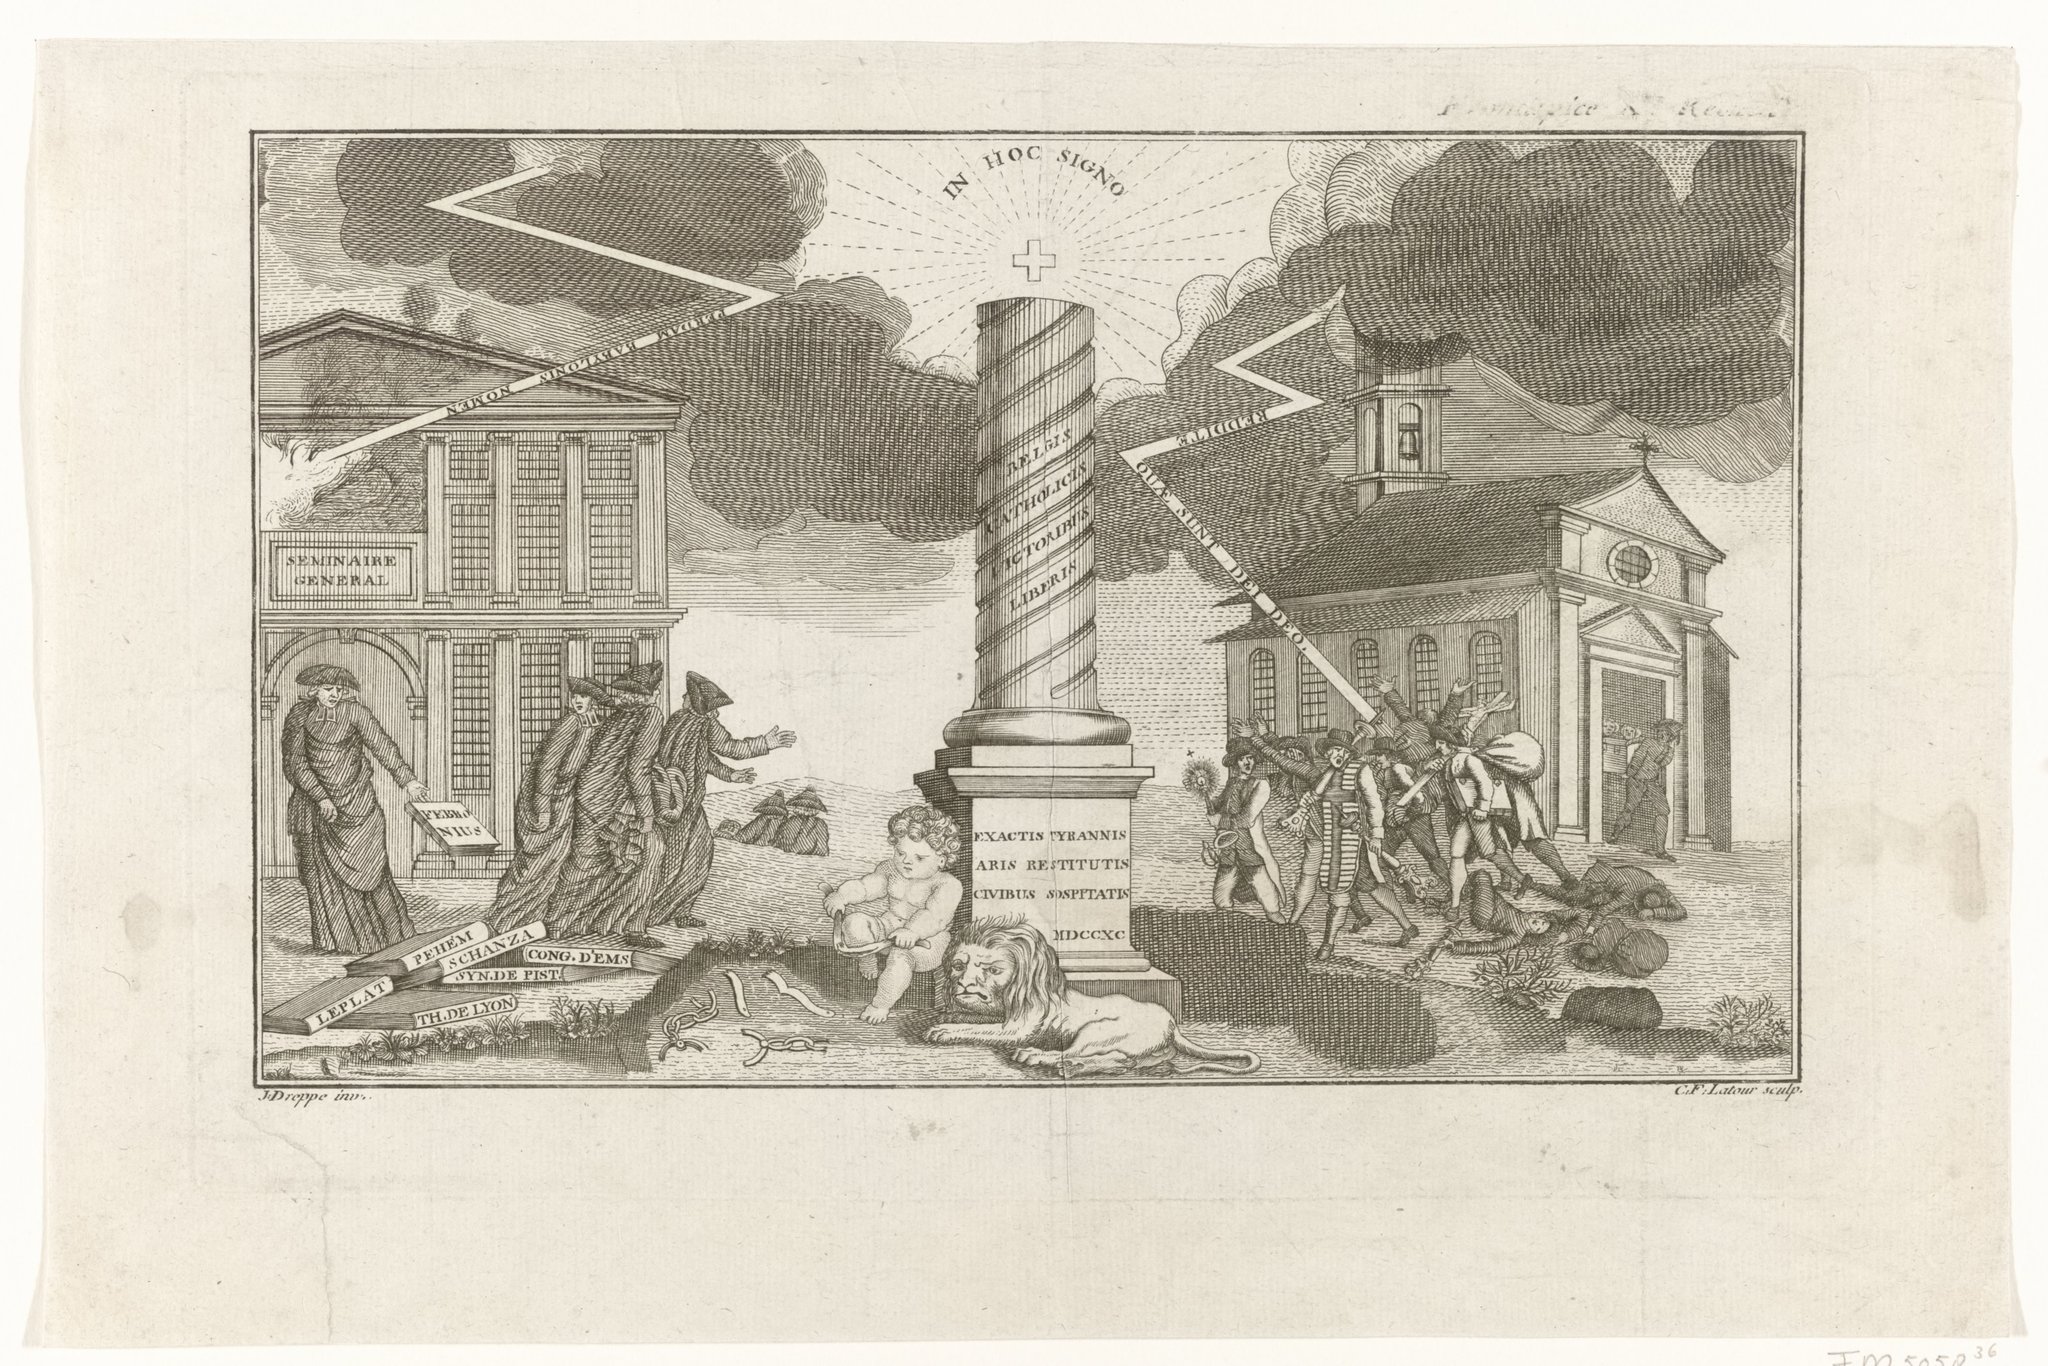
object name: print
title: Maatregelen tegen de seminaria, 1790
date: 1790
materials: paper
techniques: engraving, etching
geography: southern netherlands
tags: institution for ecclesiastical education and training, e.g. seminary, accidents with lightning, brabant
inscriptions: collector's mark: Lugt 2228, inscription: ‘Frontispice a ...’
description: Allegorische voorstelling waarin het Seminarie-Generaal en een groep kerkschenders getroffen worden door bliksemschichten. Op de voorgrond zit een naakt kind tegen een afgebroken zuil en breekt in zijn handen een juk, naast hem de Brabantse leeuw. Naar aanleiding van de Oostenrijkse wetgeving in 1787 tegen de katholieke seminaria in het land. Onderdeel van een grote groep van prenten betrekking hebbend op de gebeurtenissen van de Brabantse Omwenteling en de periode 1787-1790.